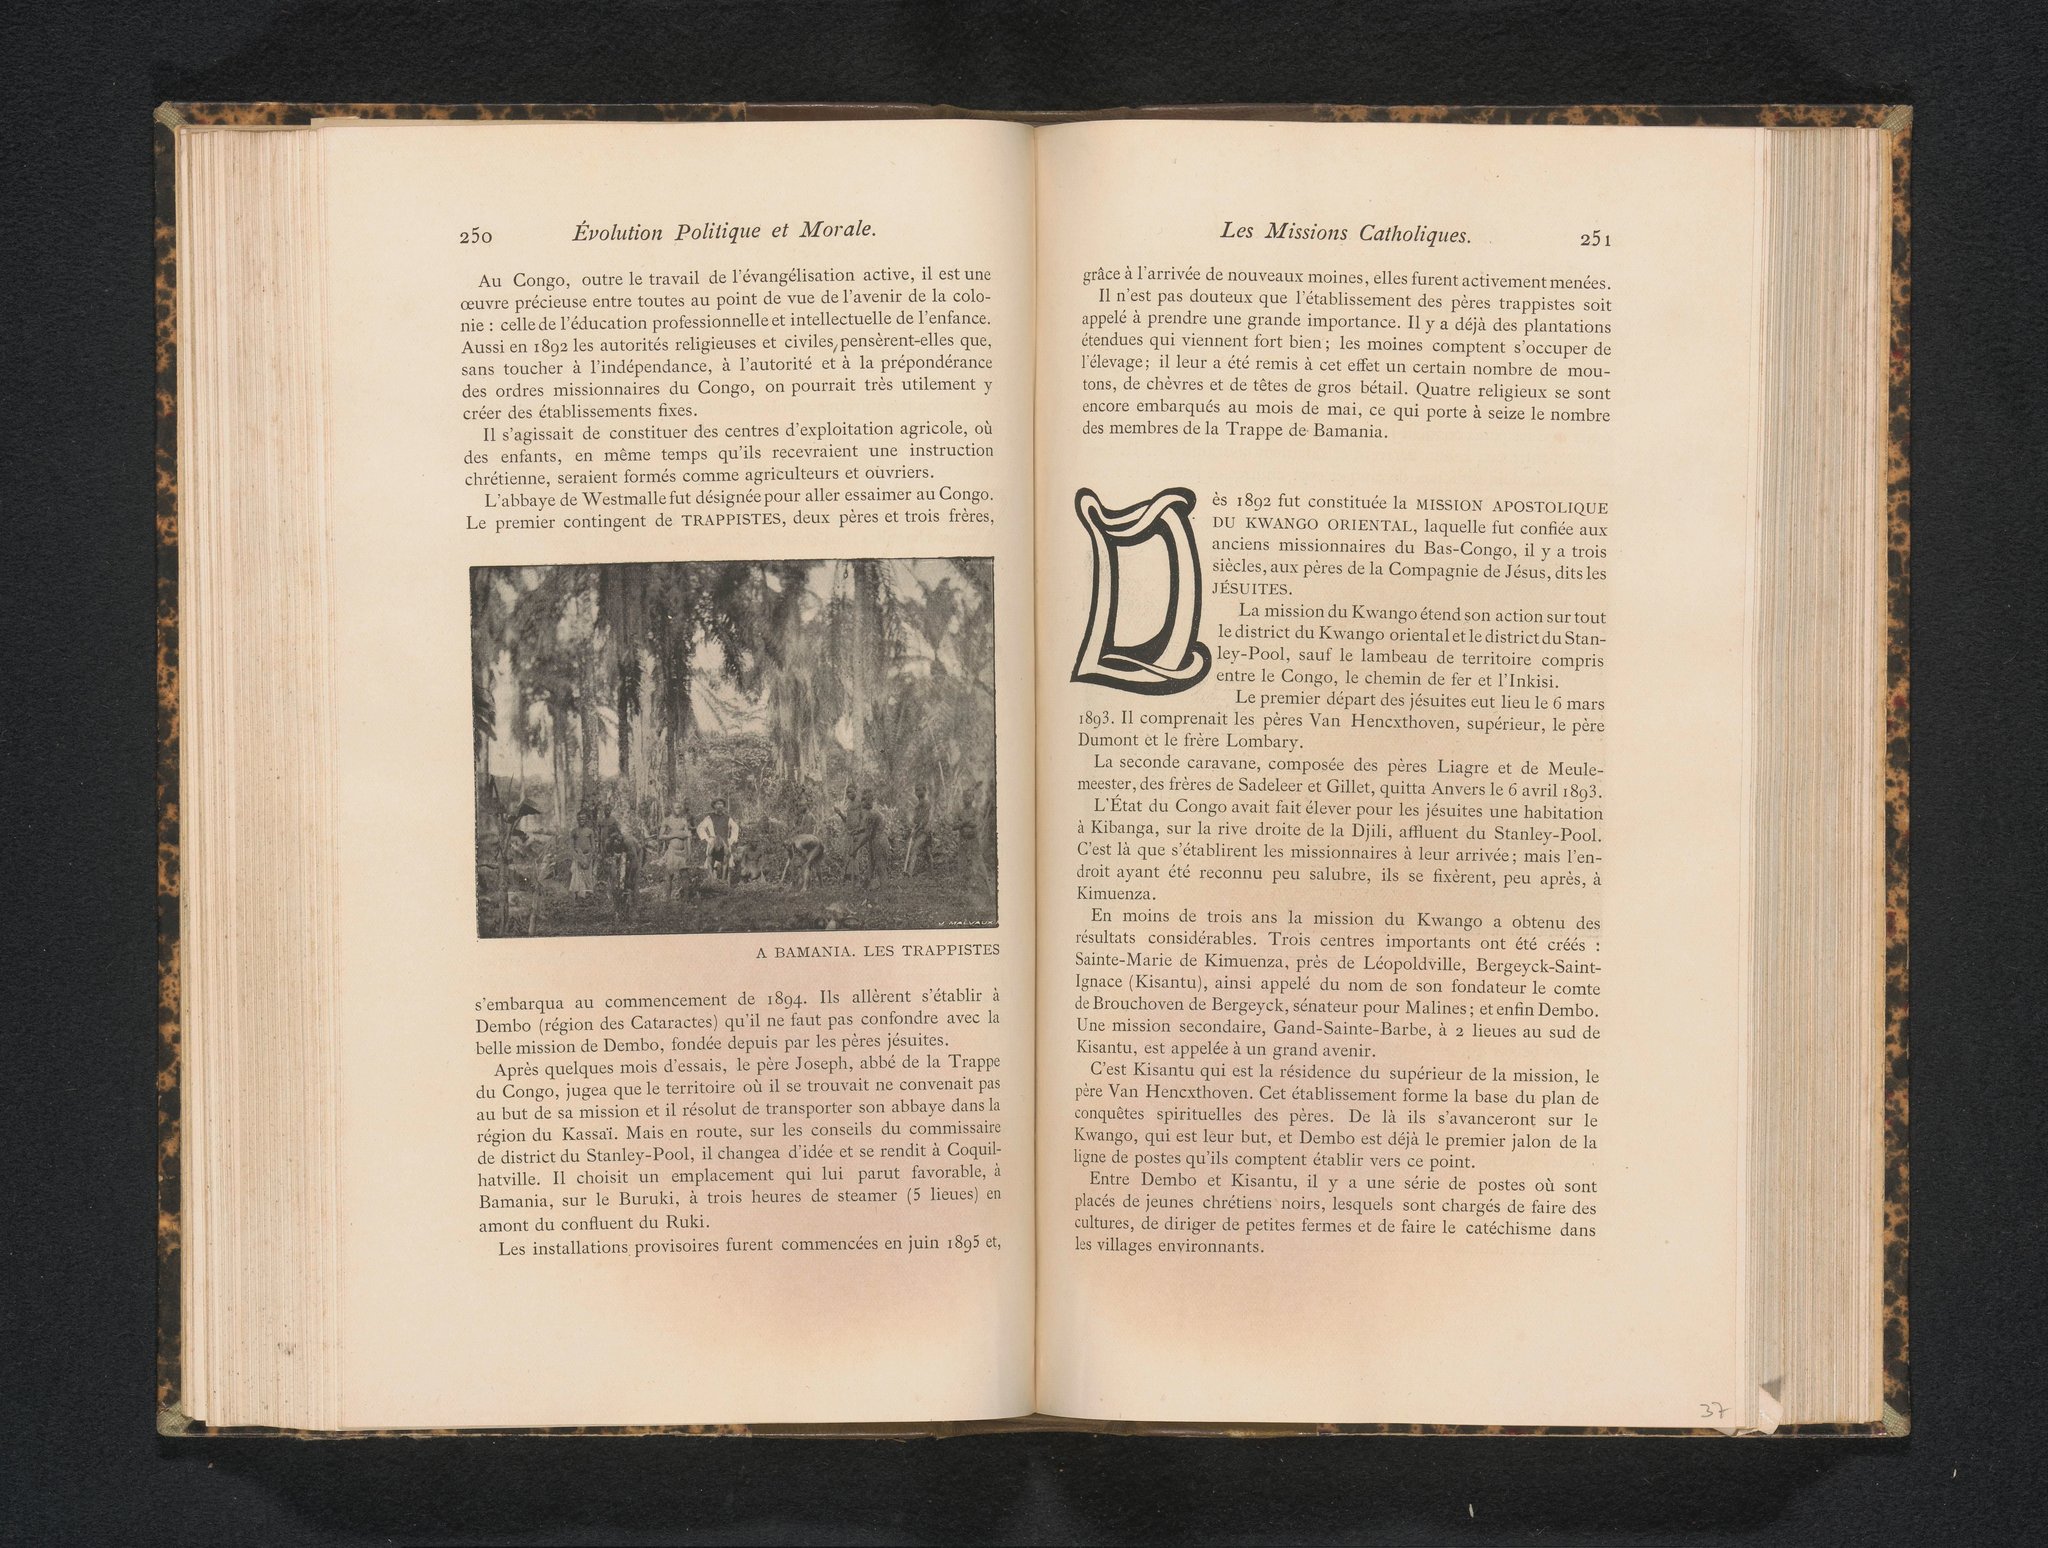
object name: page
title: A Bamania. Les Trappistes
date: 1887-1892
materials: paper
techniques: autotype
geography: congo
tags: jungle, anonymous historical persons portrayed in a group, in a group-portrait